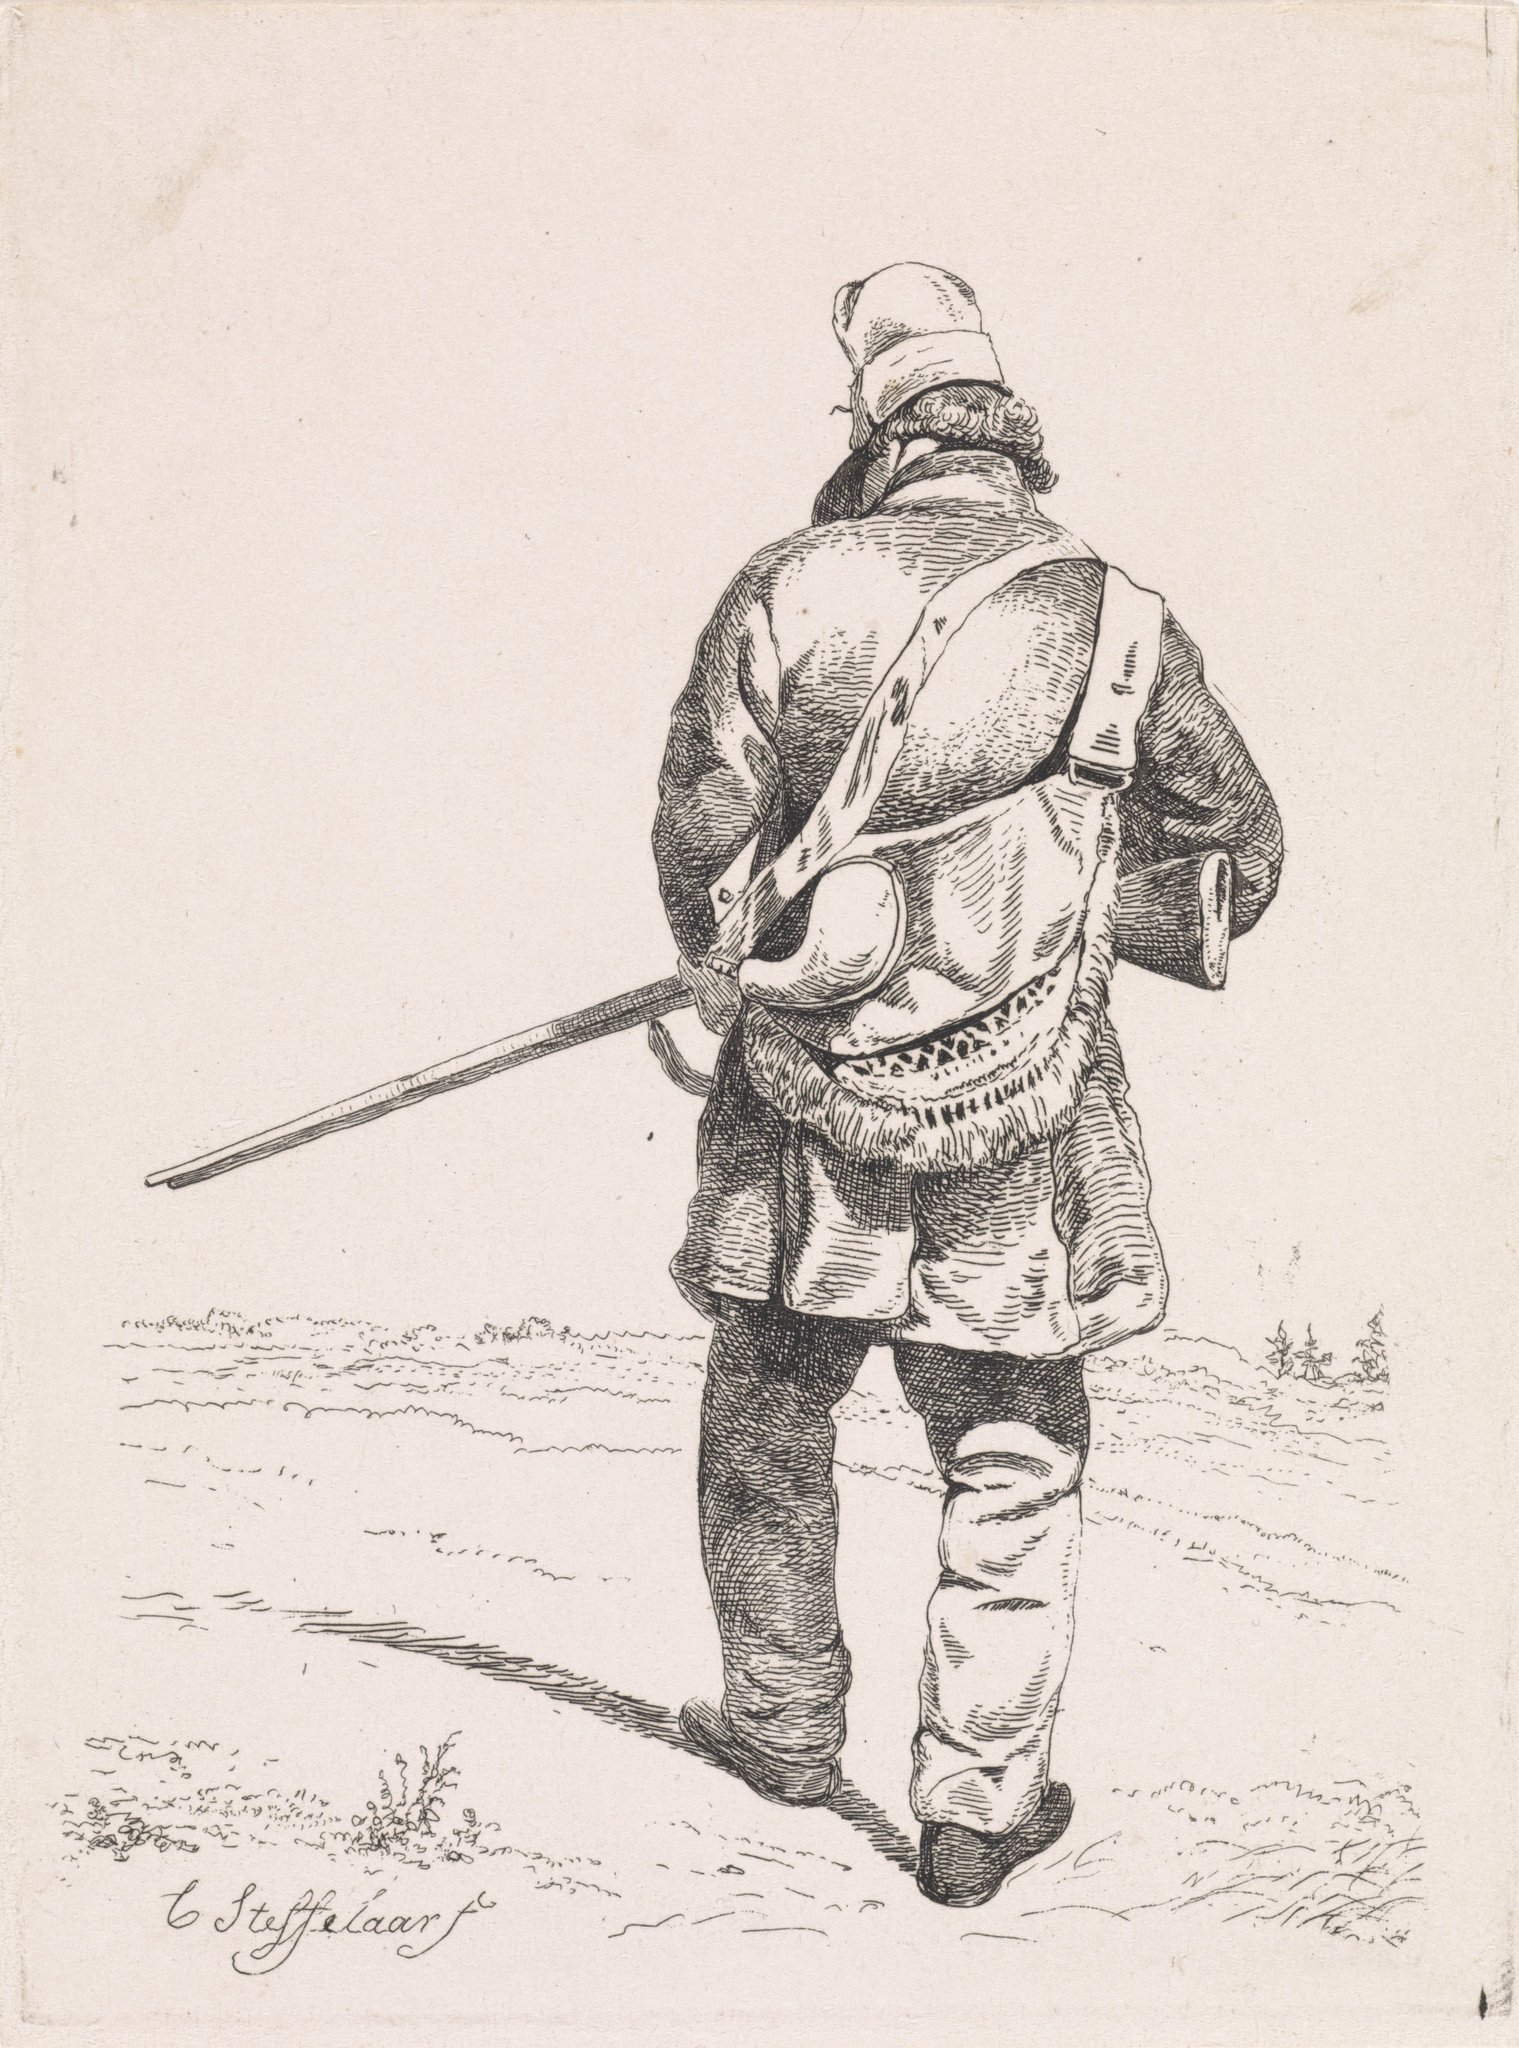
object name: print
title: Jager op de rug gezien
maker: cornelis steffelaar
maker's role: draughtsman, painter, print maker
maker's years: 1797-1861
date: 1807-1861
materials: paper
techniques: etching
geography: amsterdam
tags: hunter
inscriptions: collector's mark: Lugt 2228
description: Een jager, op de rug gezien, houdt een geweer in zijn handen. Over zijn schouder draagt hij een tas.